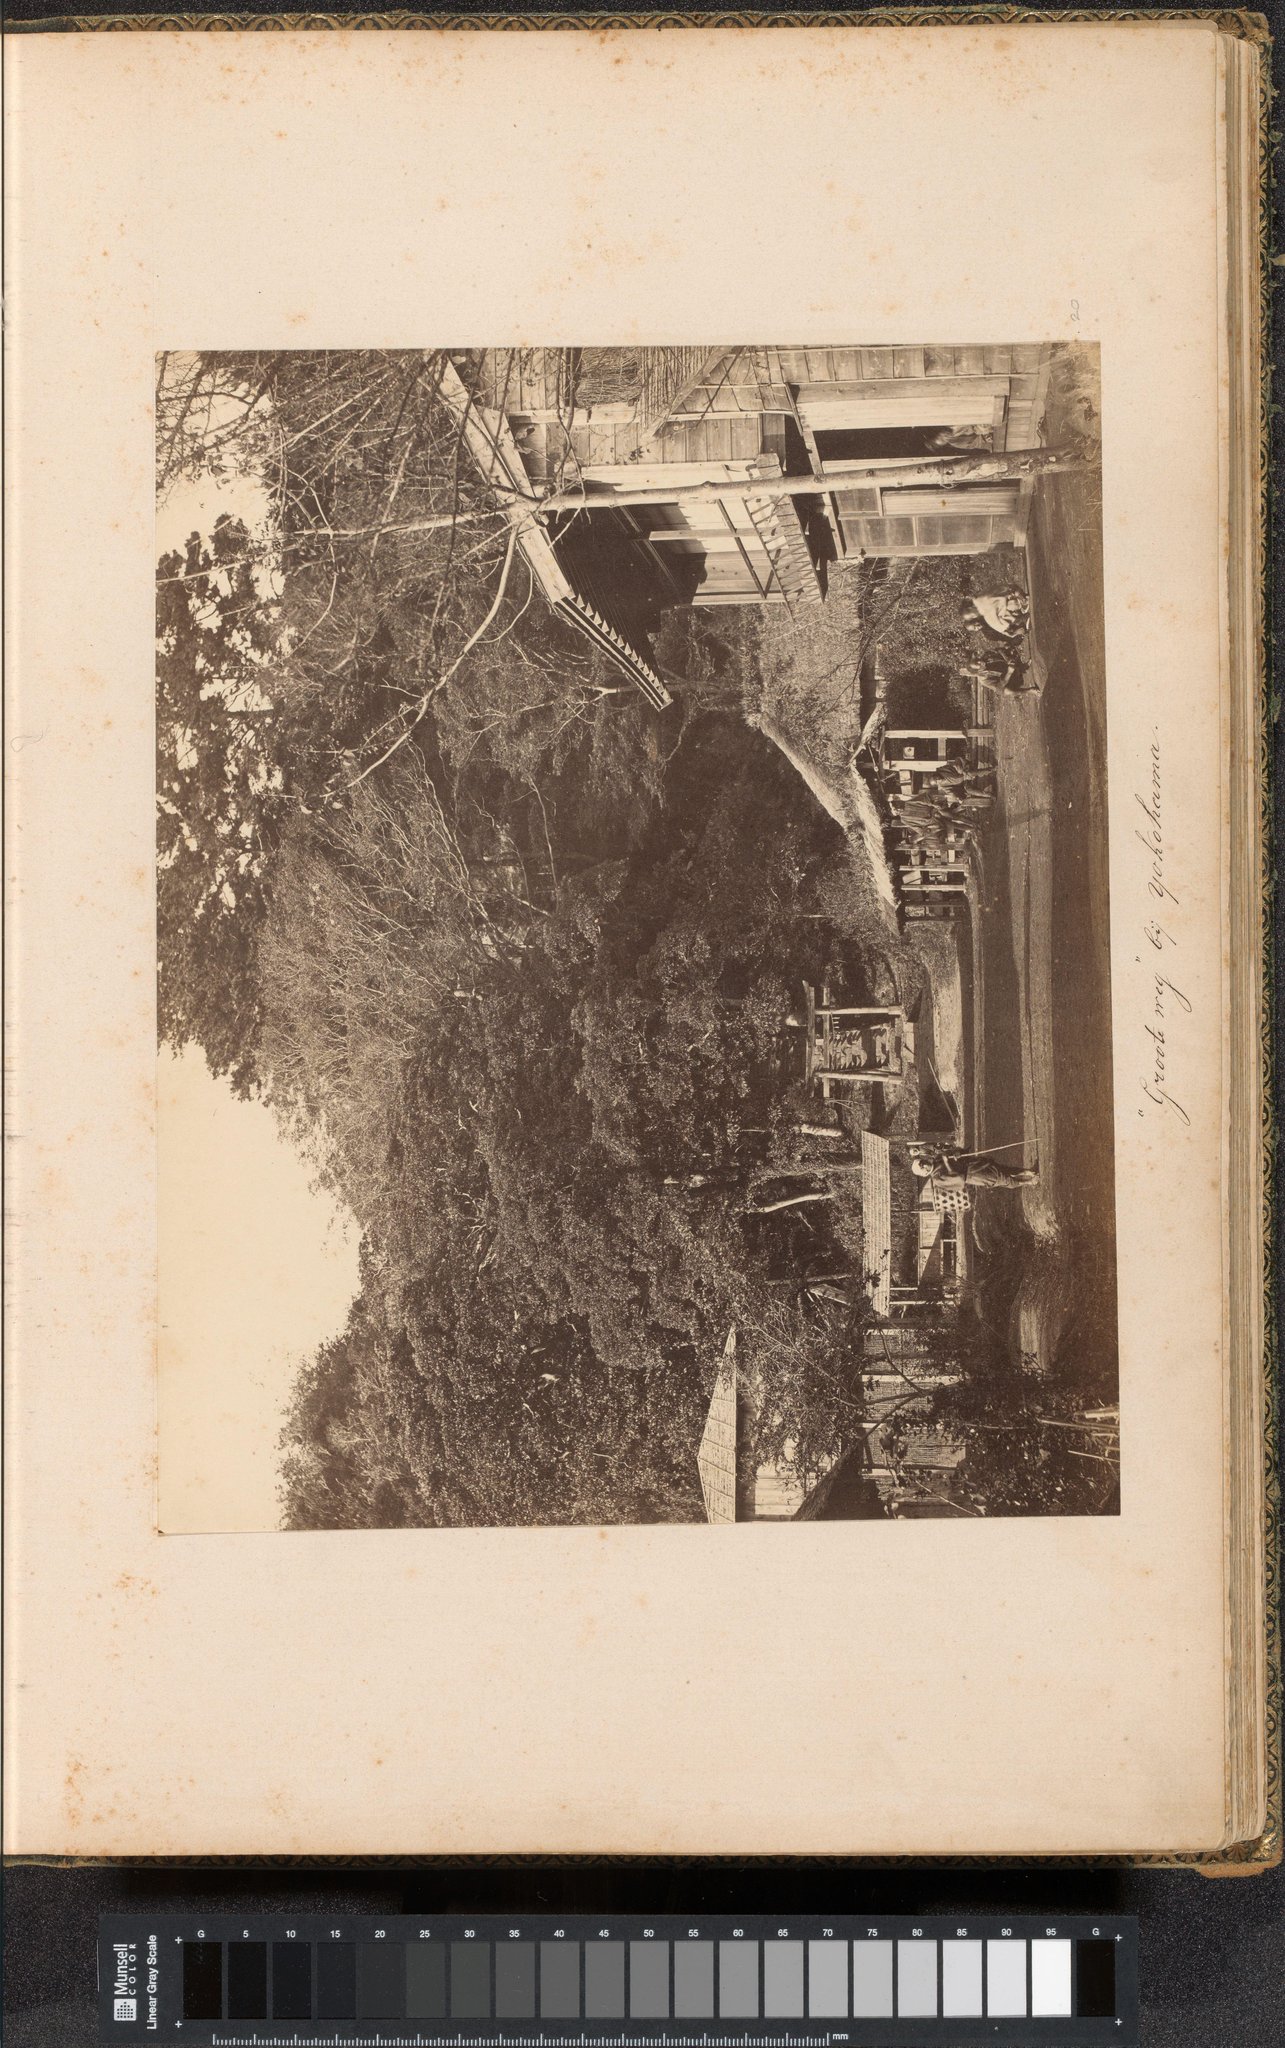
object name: album leaf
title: Gezicht op de Grote Weg bij Yokohama met mensen, woningen en bomen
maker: Anonymous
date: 1860-1870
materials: paper, photographic support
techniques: albumen print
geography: yokohama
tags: public road, street (+ city(-scape) with figures, staffage)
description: Onderdeel van Fotoalbum van Robert Daniel Crommelin (1841-1907).